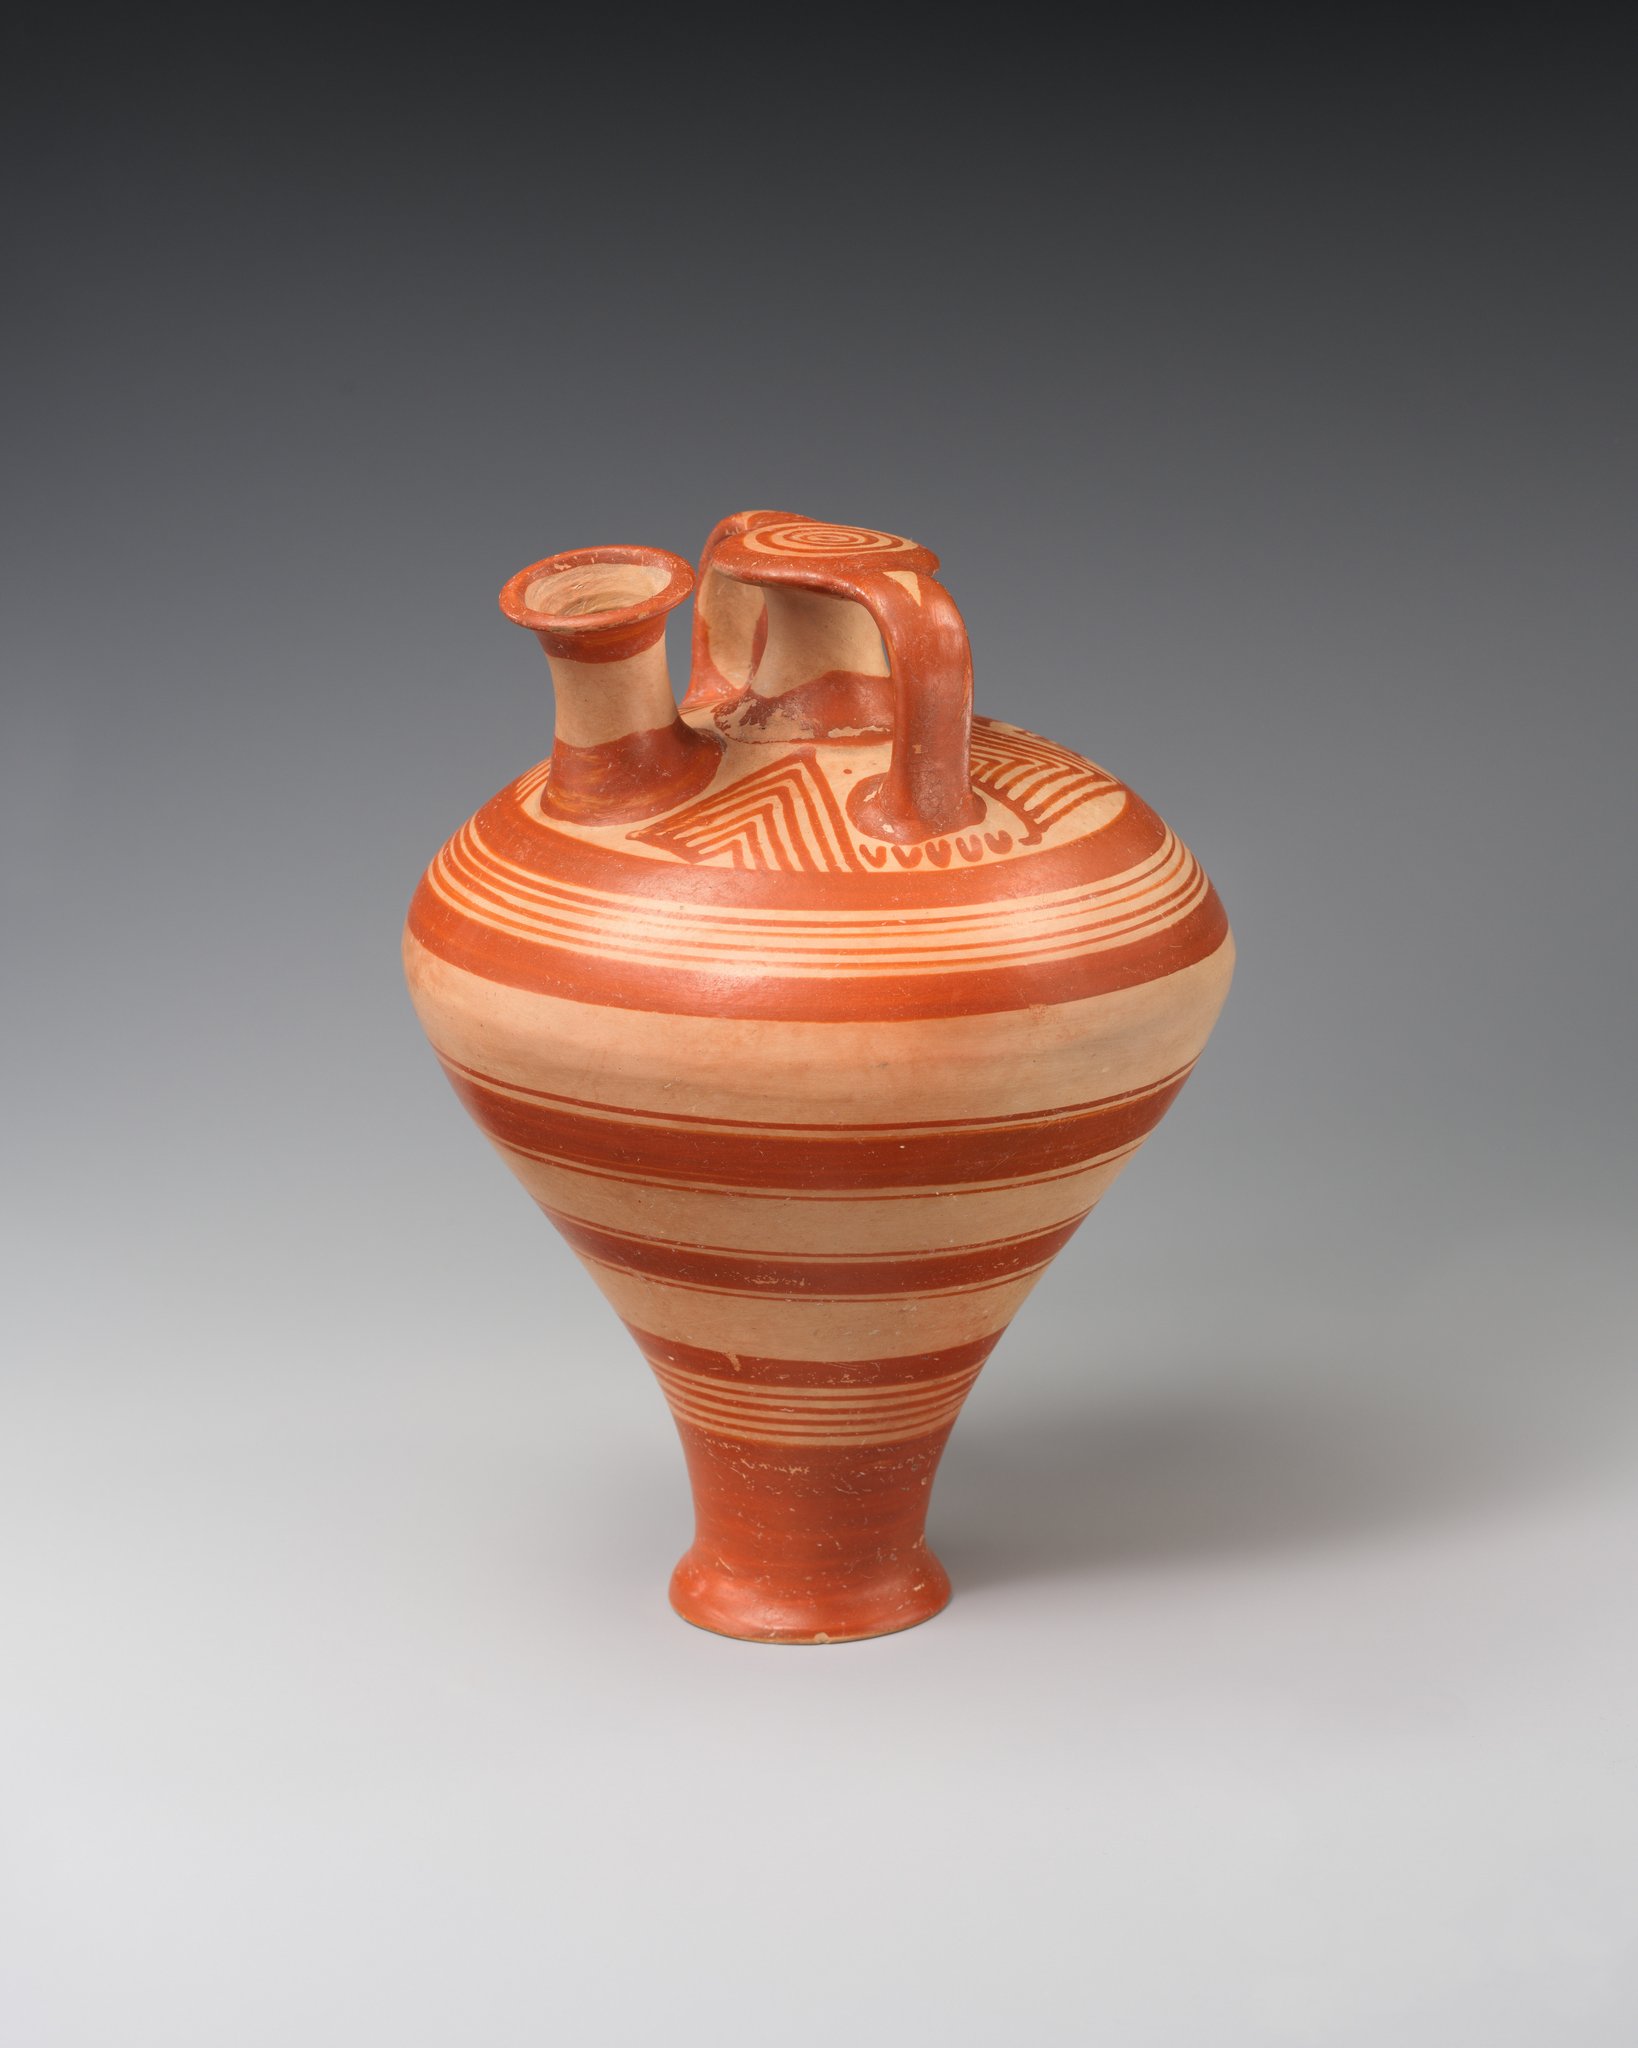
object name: false necked jar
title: Terracotta stirrup jar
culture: mycenaean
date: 1300-1230 BCE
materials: terracotta